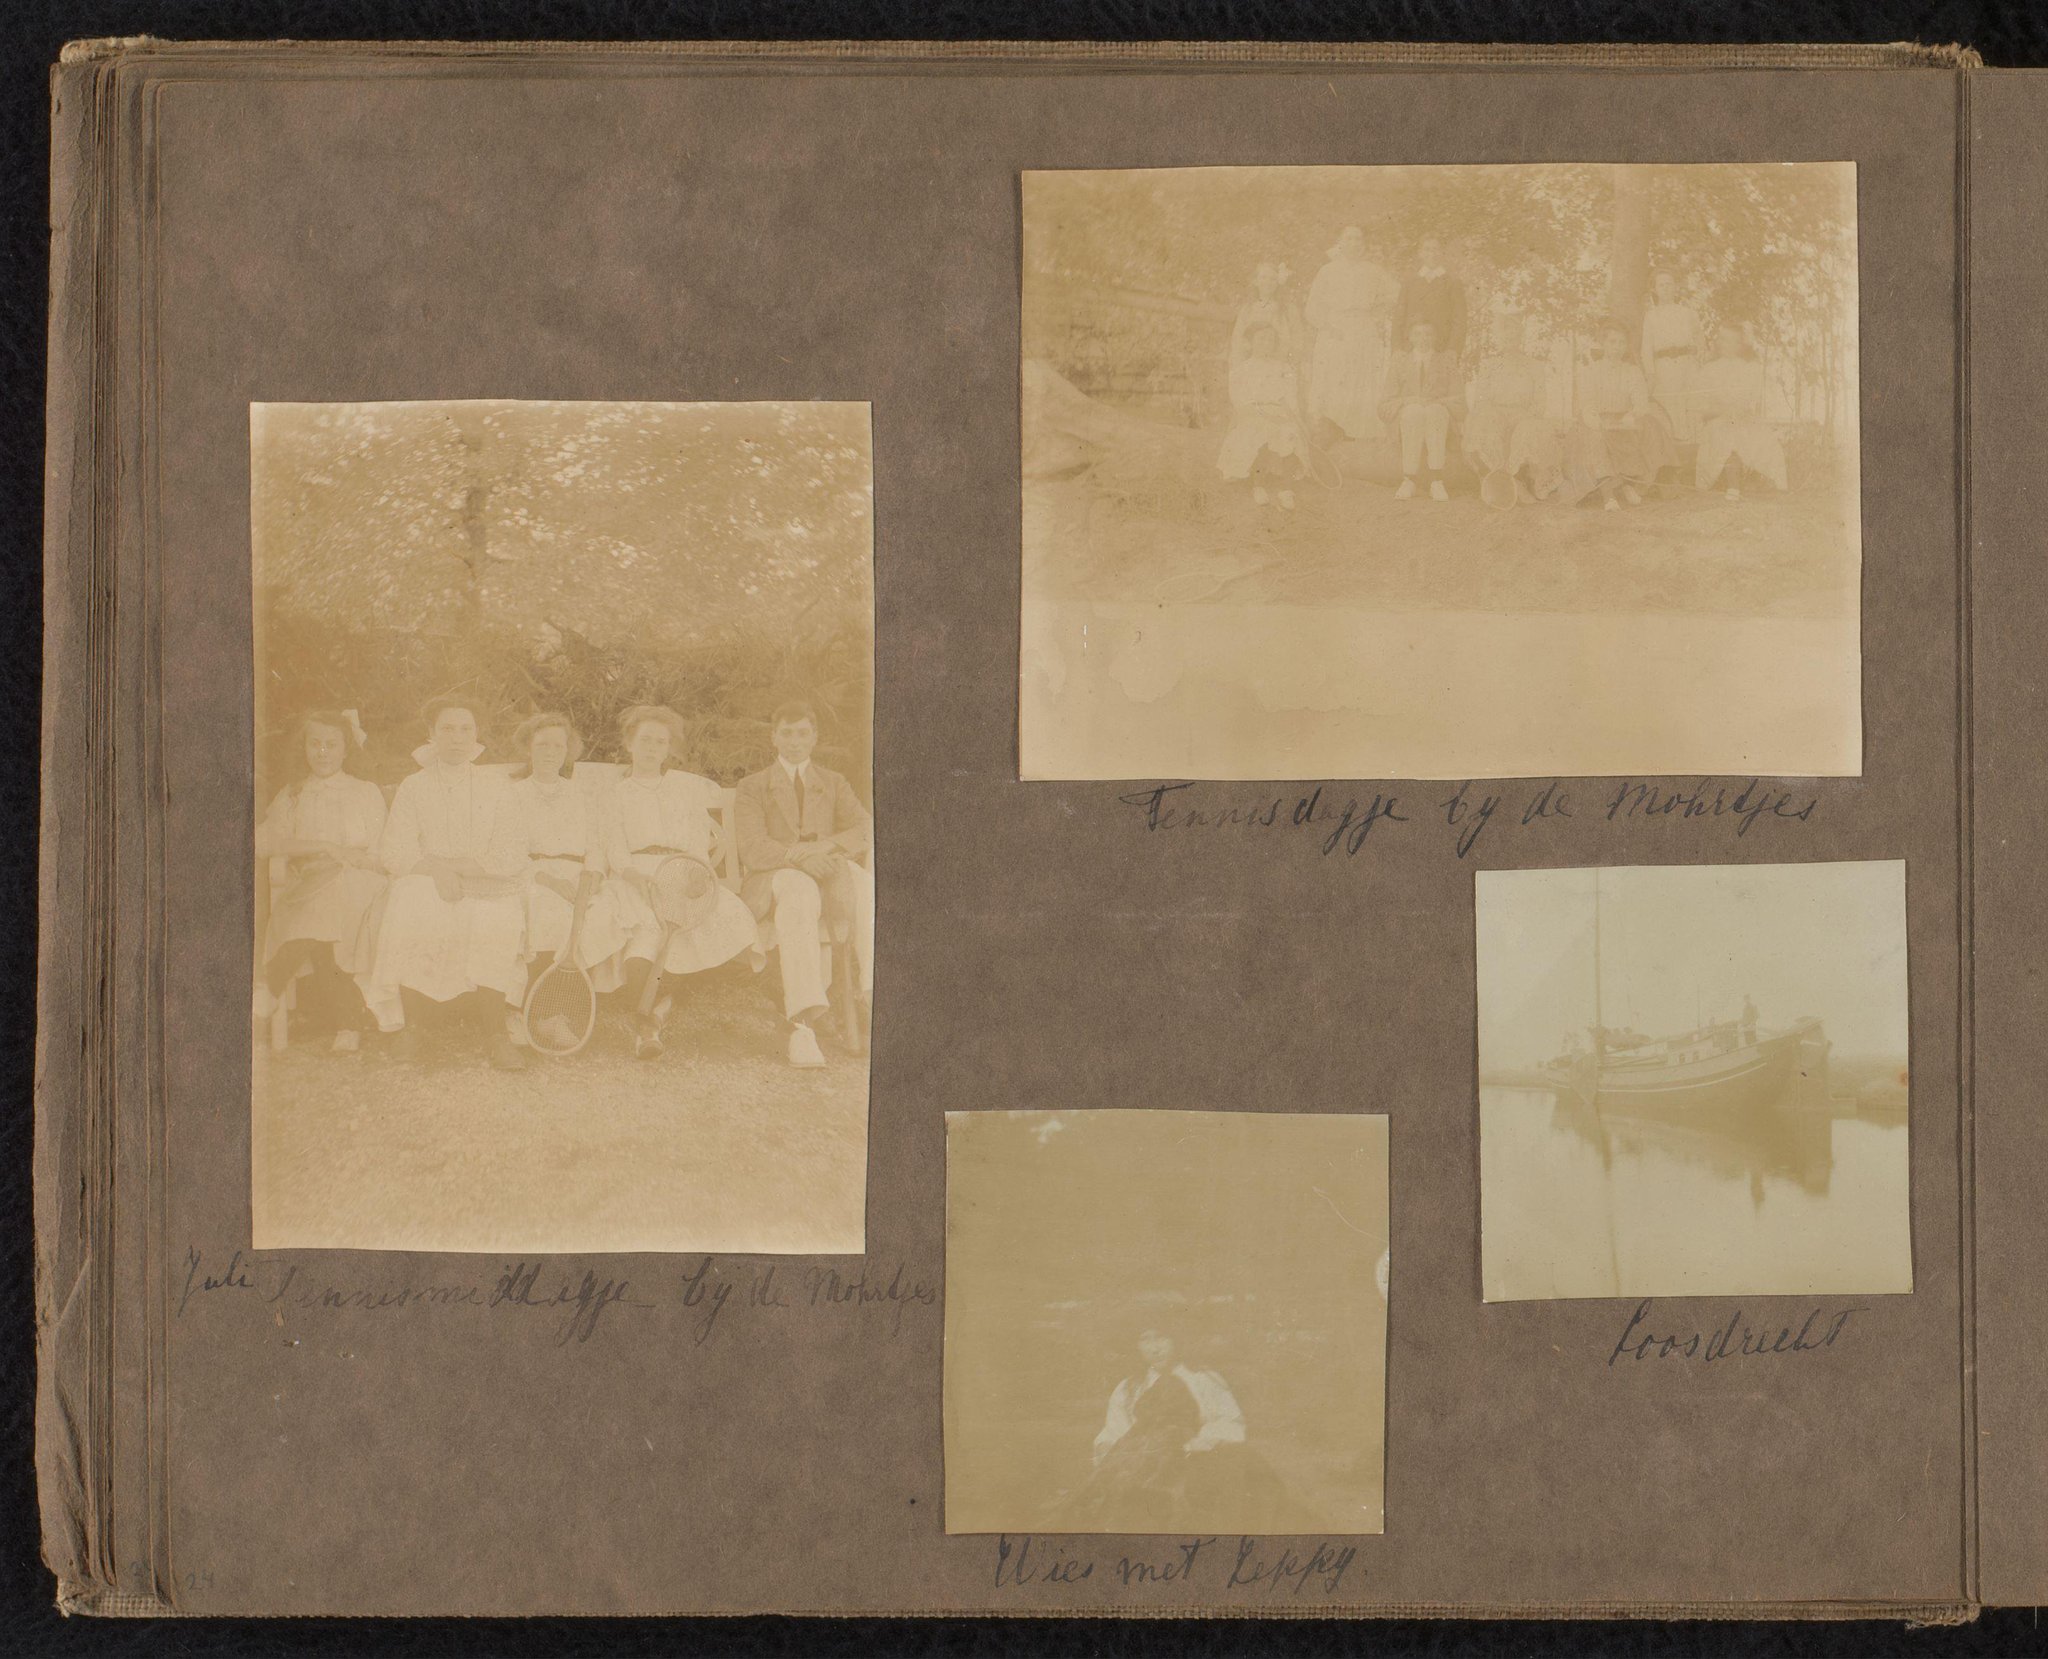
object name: album leaf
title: Vier foto's van Loentje en Milly Onnen met Lilly Mohr en anderen bij een tennisbaan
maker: carolina frederika onnen (lien/loen)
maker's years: 1896-1983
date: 1907-1910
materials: paper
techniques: gelatin silver print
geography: netherlands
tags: batavia, amsterdam, carolina frederika onnen (lien/loen), tennis, lawn-tennis, sailing-ship, sailing-boat, historical persons - bb - woman, dog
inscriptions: inscription: ‘Tennisdagje bij de Mohrtjes’, inscription: ‘Wies met Zeppy’, inscription: ‘Loosdrecht’, inscription: ‘Juli tennismiddagje bij de Mohrtjes’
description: Deze foto's maken deel uit van een album.